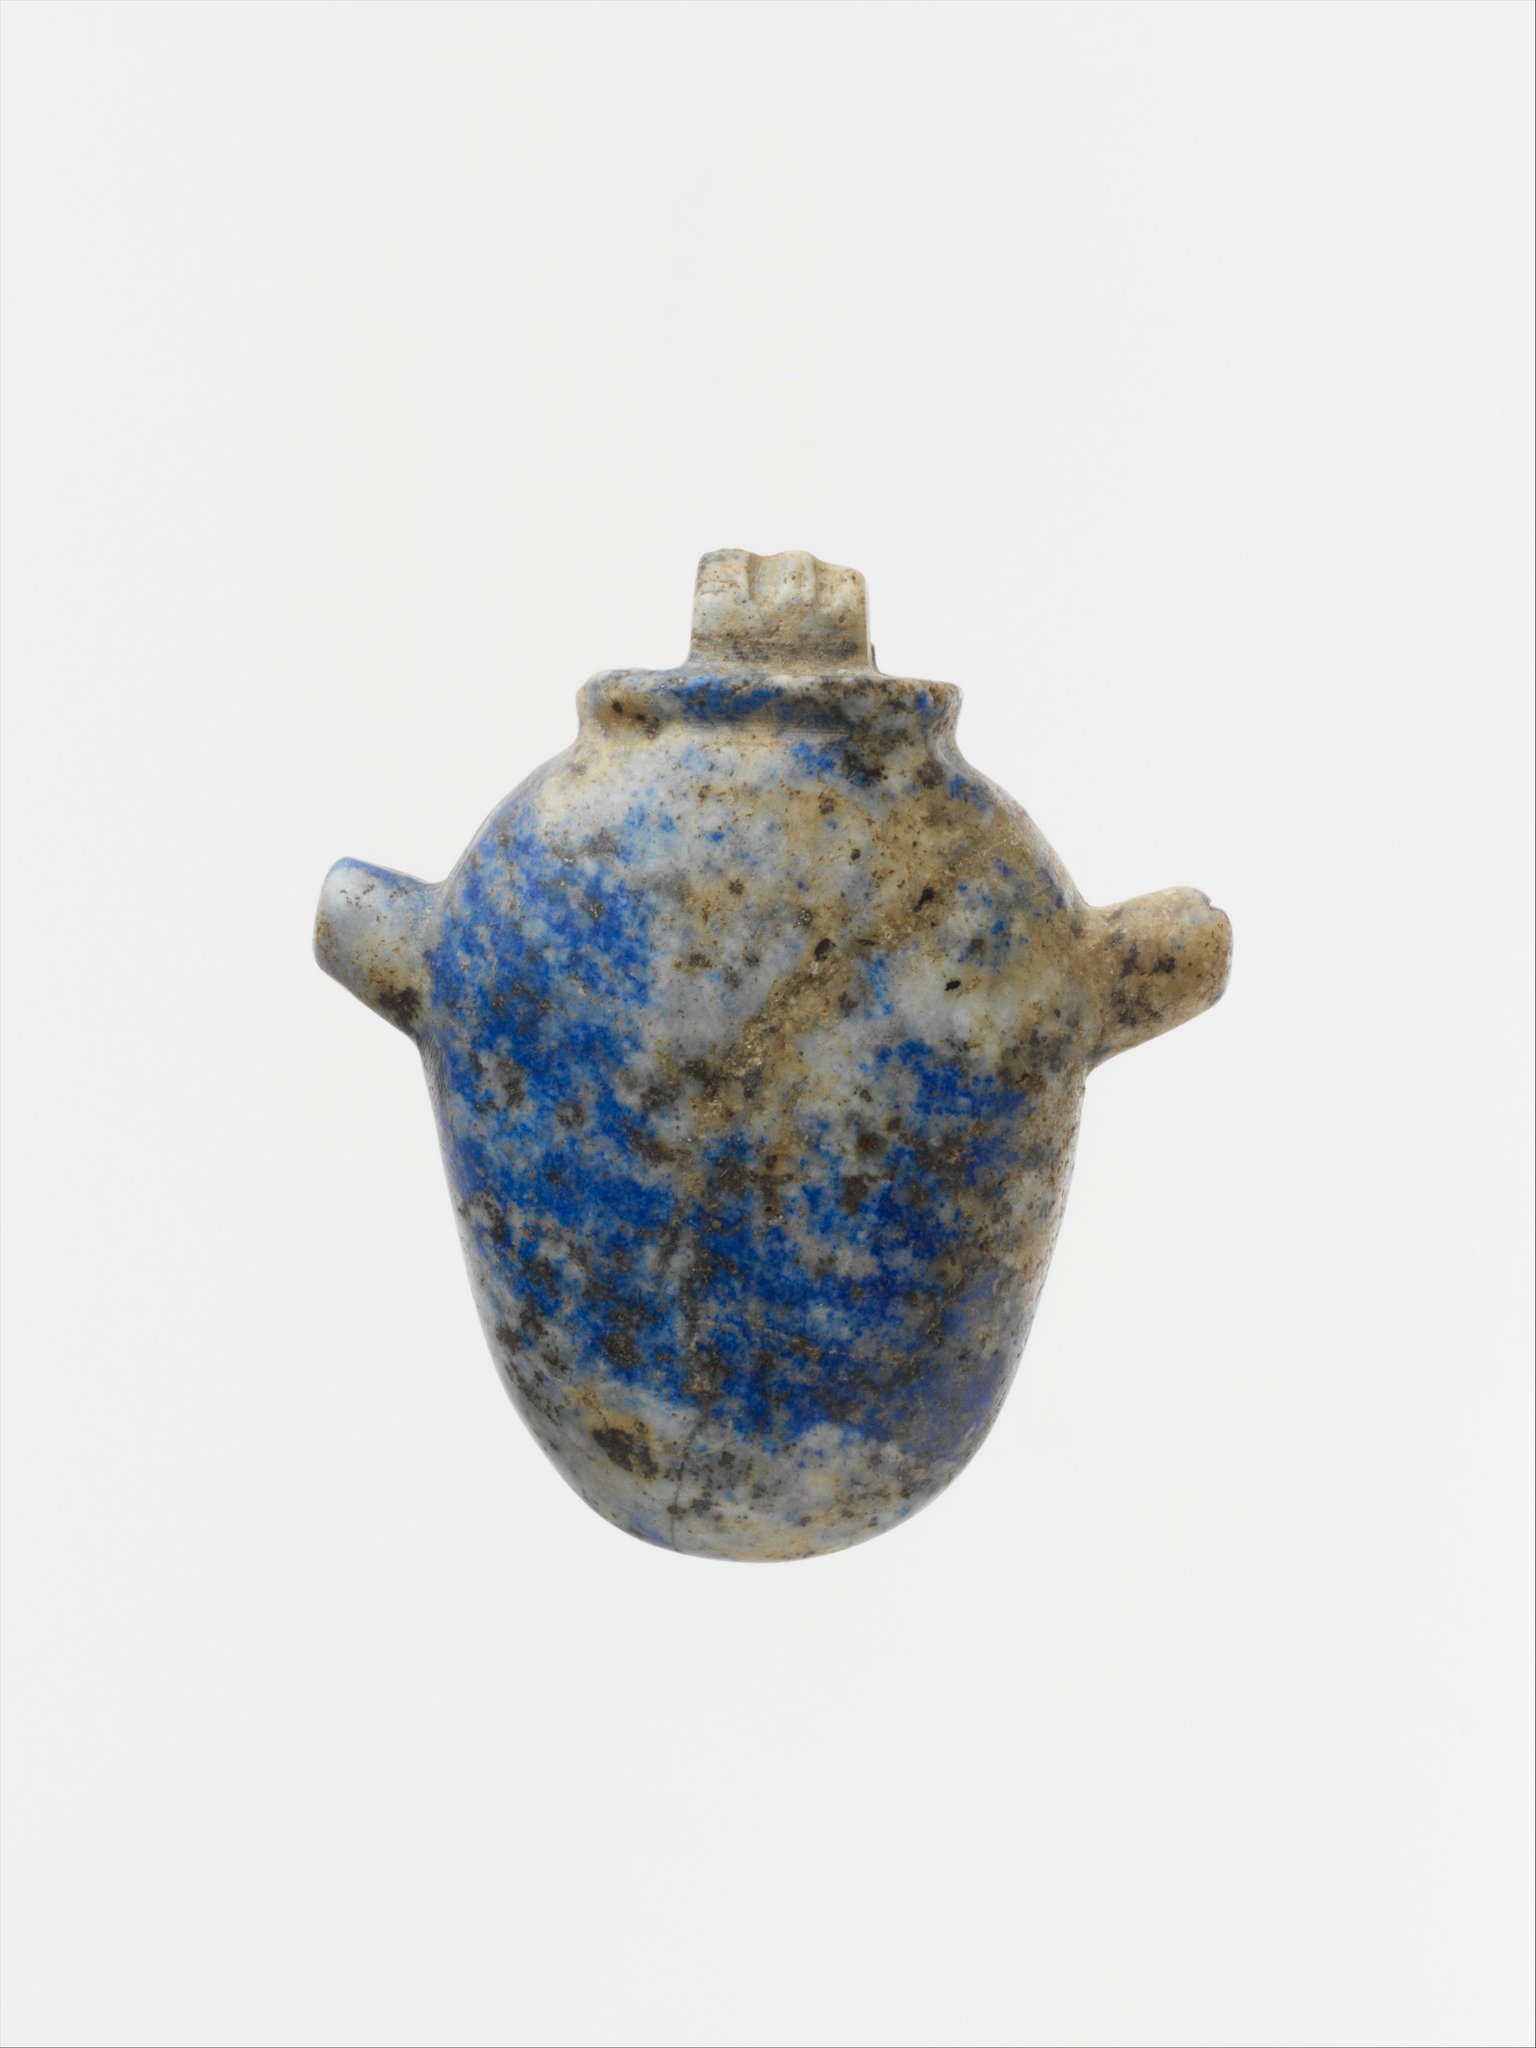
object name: amulet pendant, heart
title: Lapis lazuli heart amulet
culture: egyptian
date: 664-334 BCE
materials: lapis lazuli